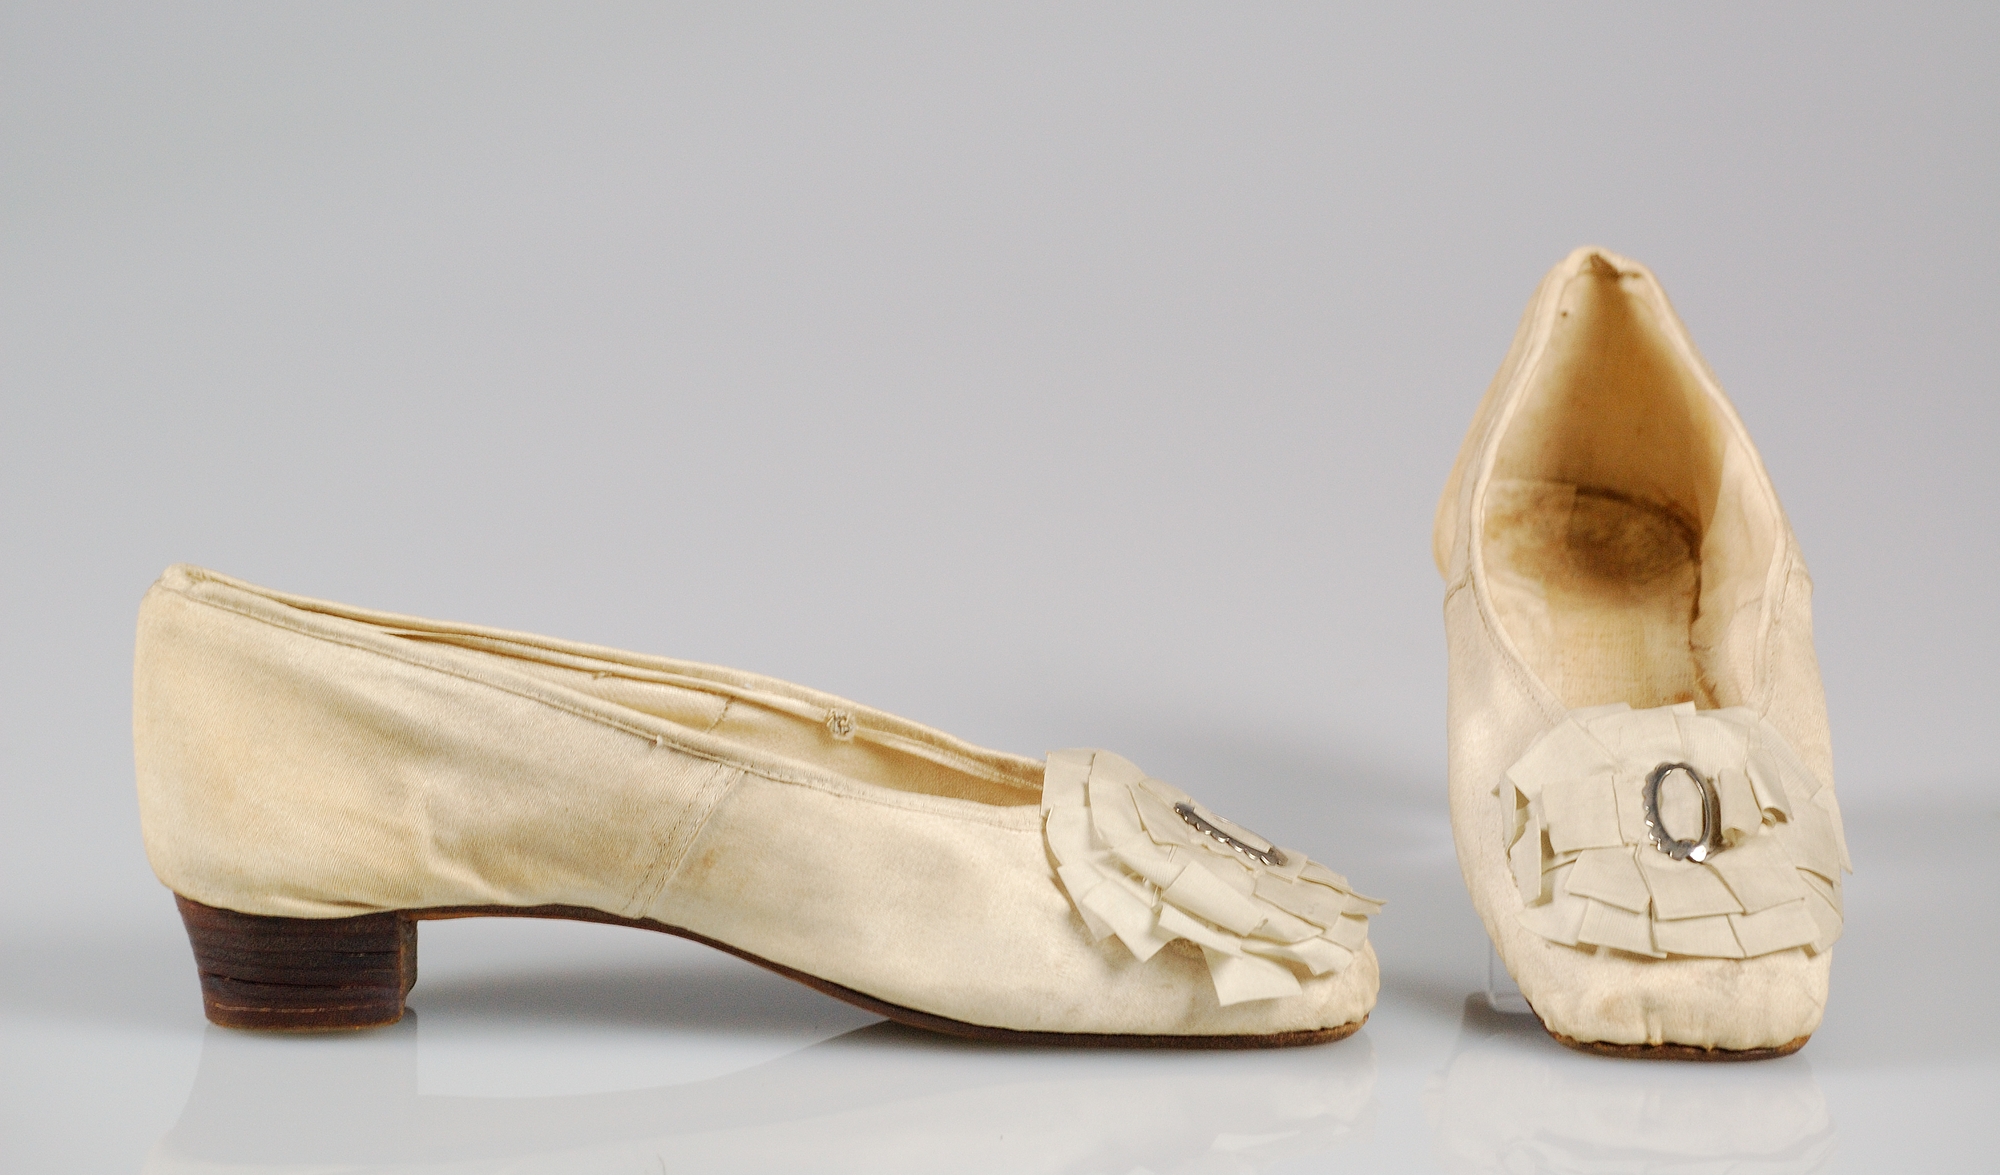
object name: wedding slipper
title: Wedding slippers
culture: american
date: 1855-1865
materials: silk, wool